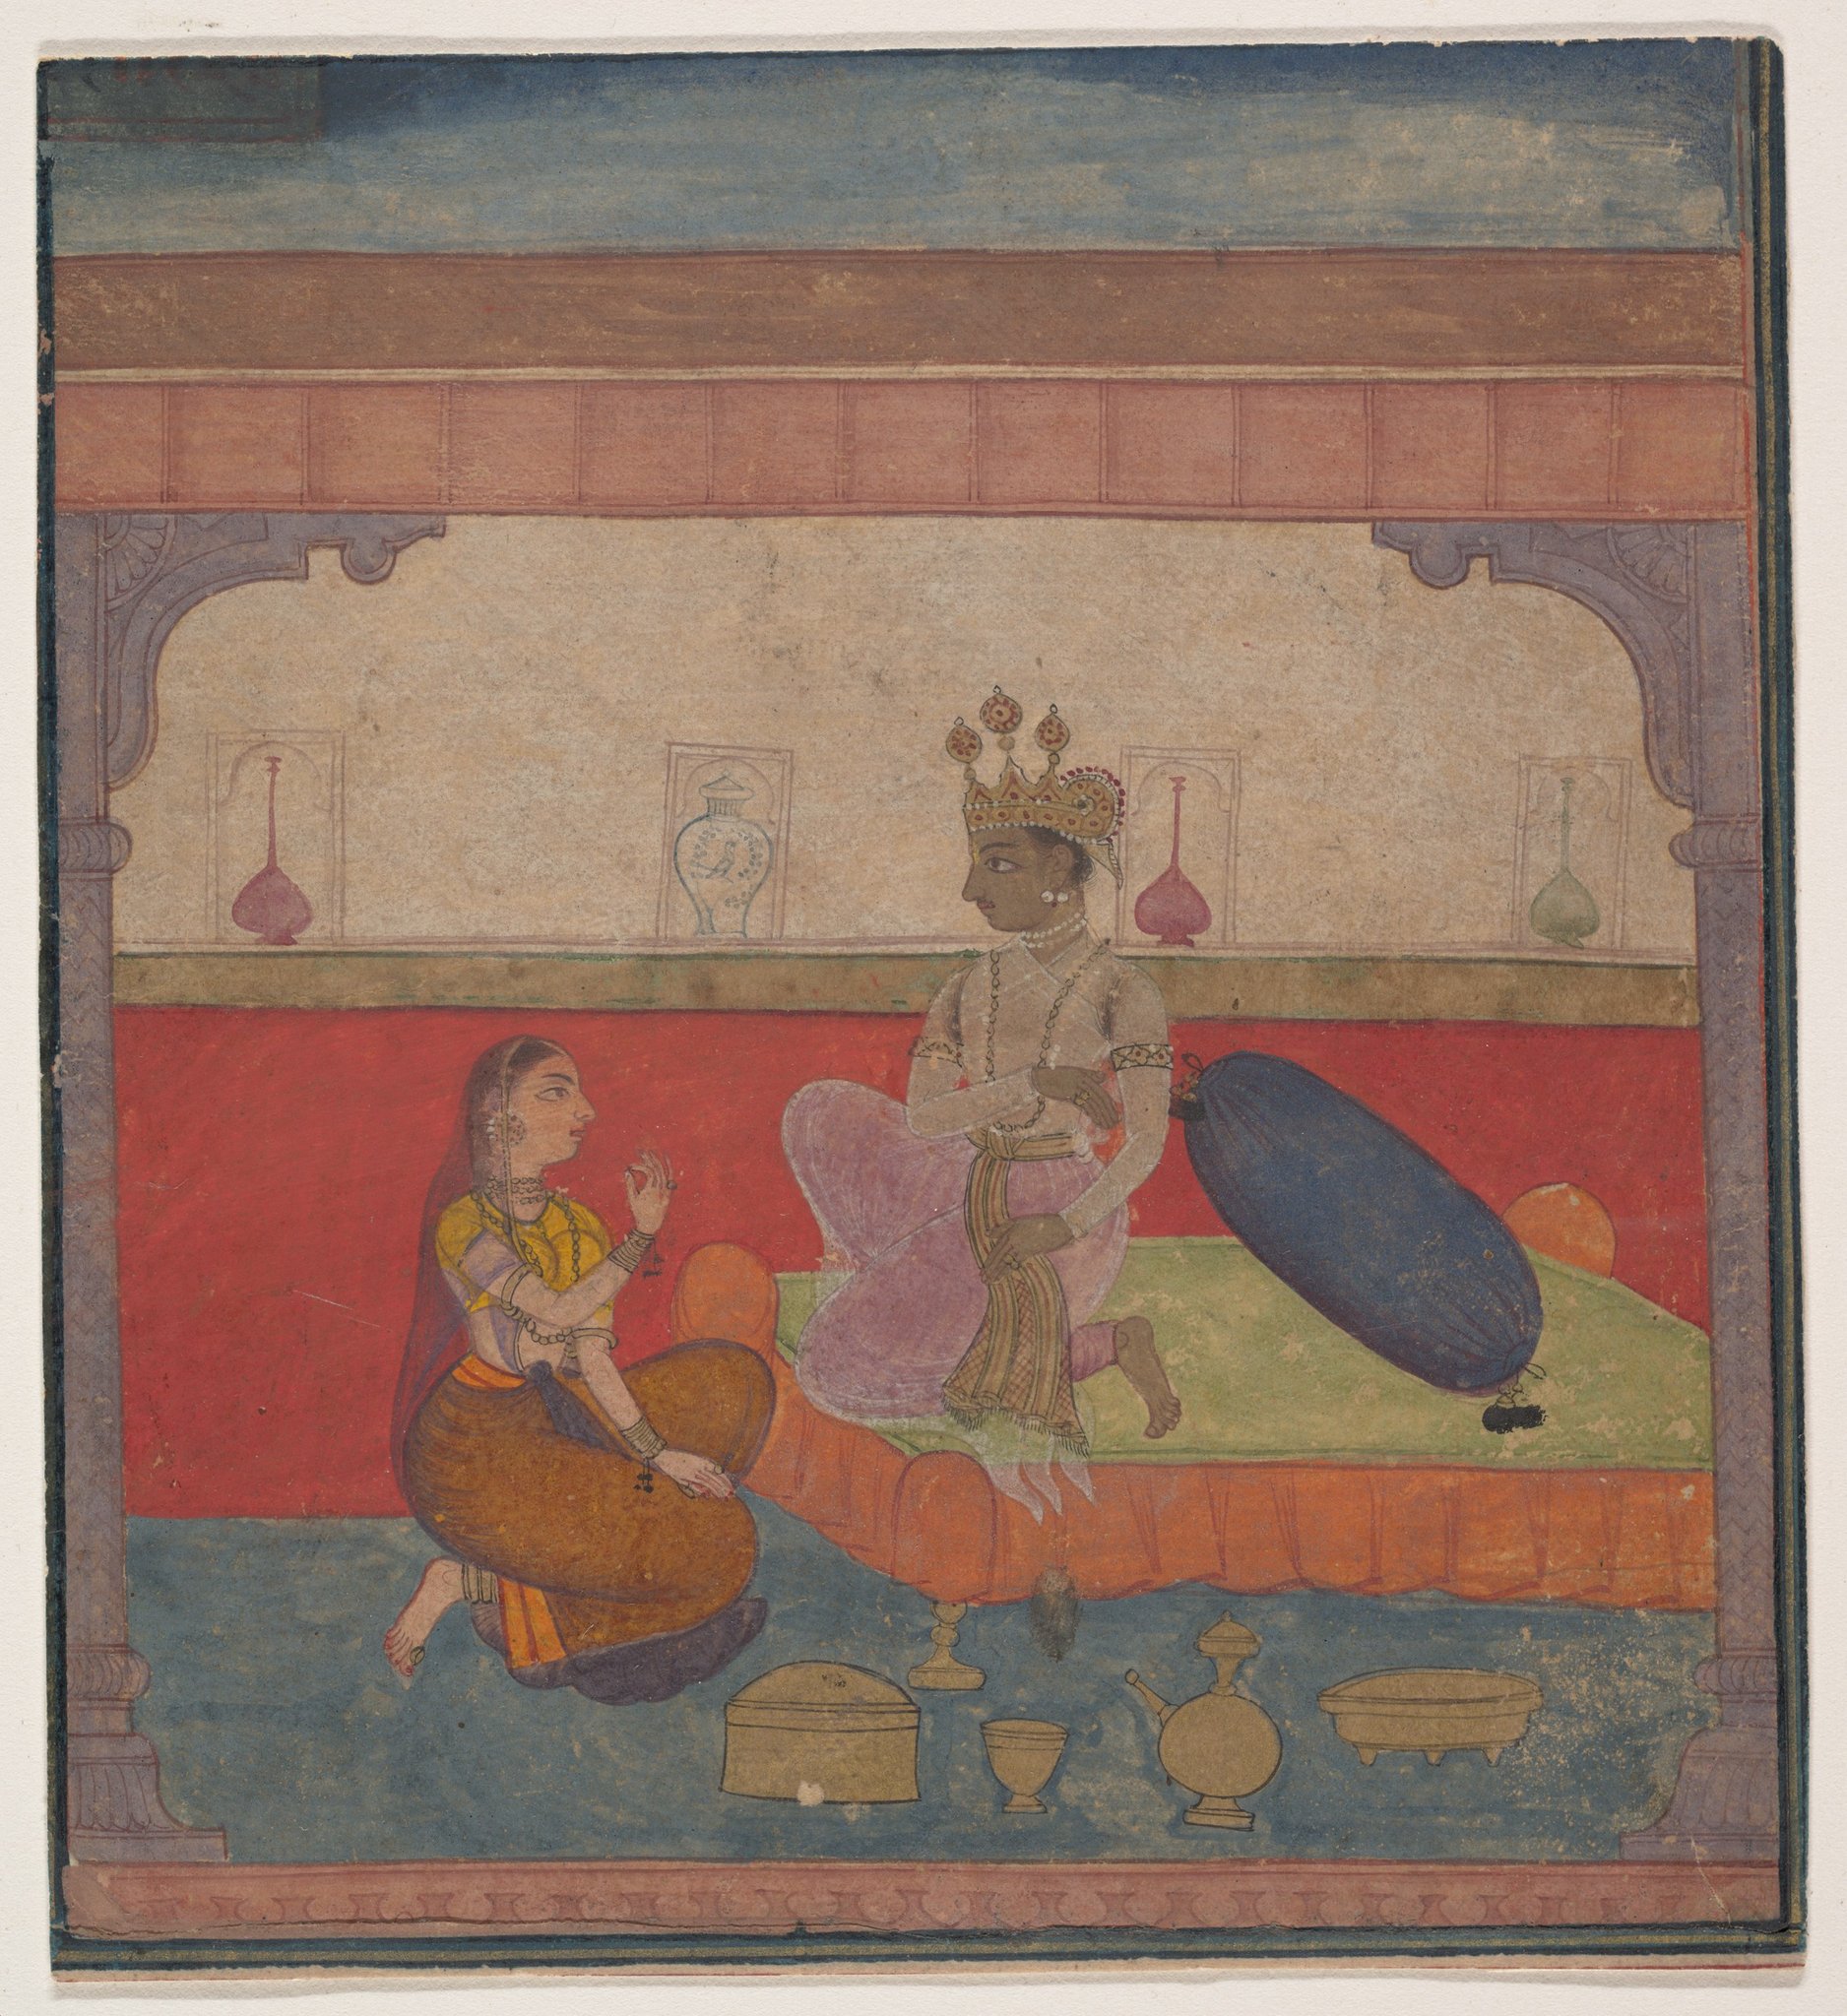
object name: folio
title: Radha Speaks to Krishna: Page from the Boston Rasikapriya (Lover's Breviary)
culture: indian or rajasthan or amber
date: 1610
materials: gold, ink, paper, watercolor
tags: women,krishna,radha,beds